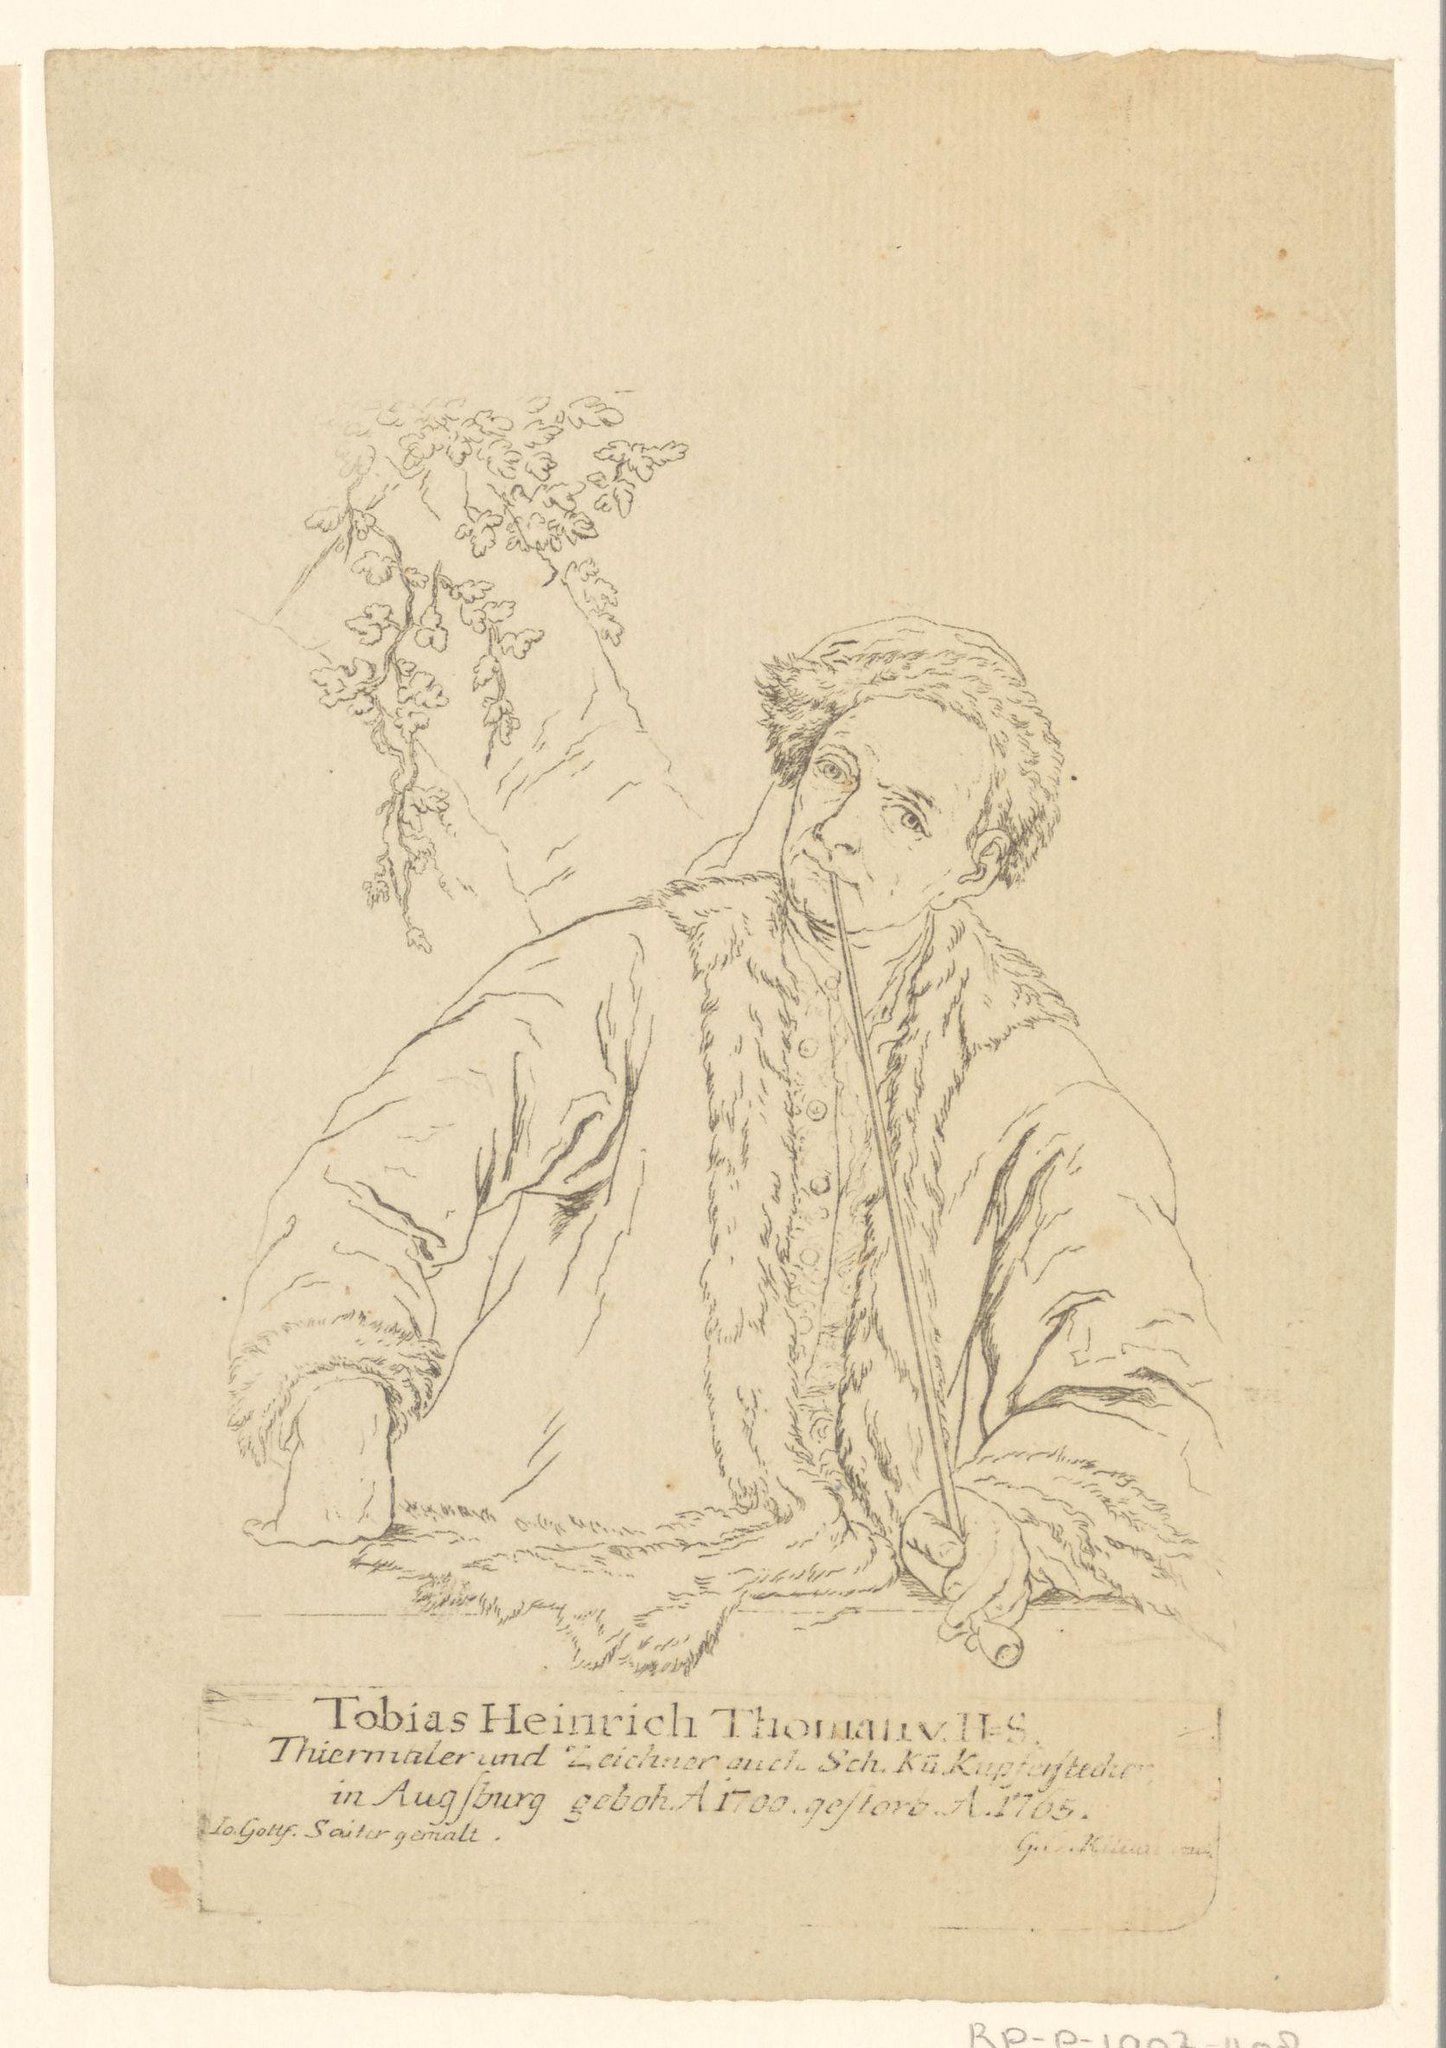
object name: print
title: Portret van Tobias Heinrich Thomann von Hagelstein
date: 1765-1781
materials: paper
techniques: etching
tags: painter, artist, tobias heinrich thomann von hagelstein, historical persons, portrait, self-portrait of graphic artist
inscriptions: collector's mark: Lugt 2228